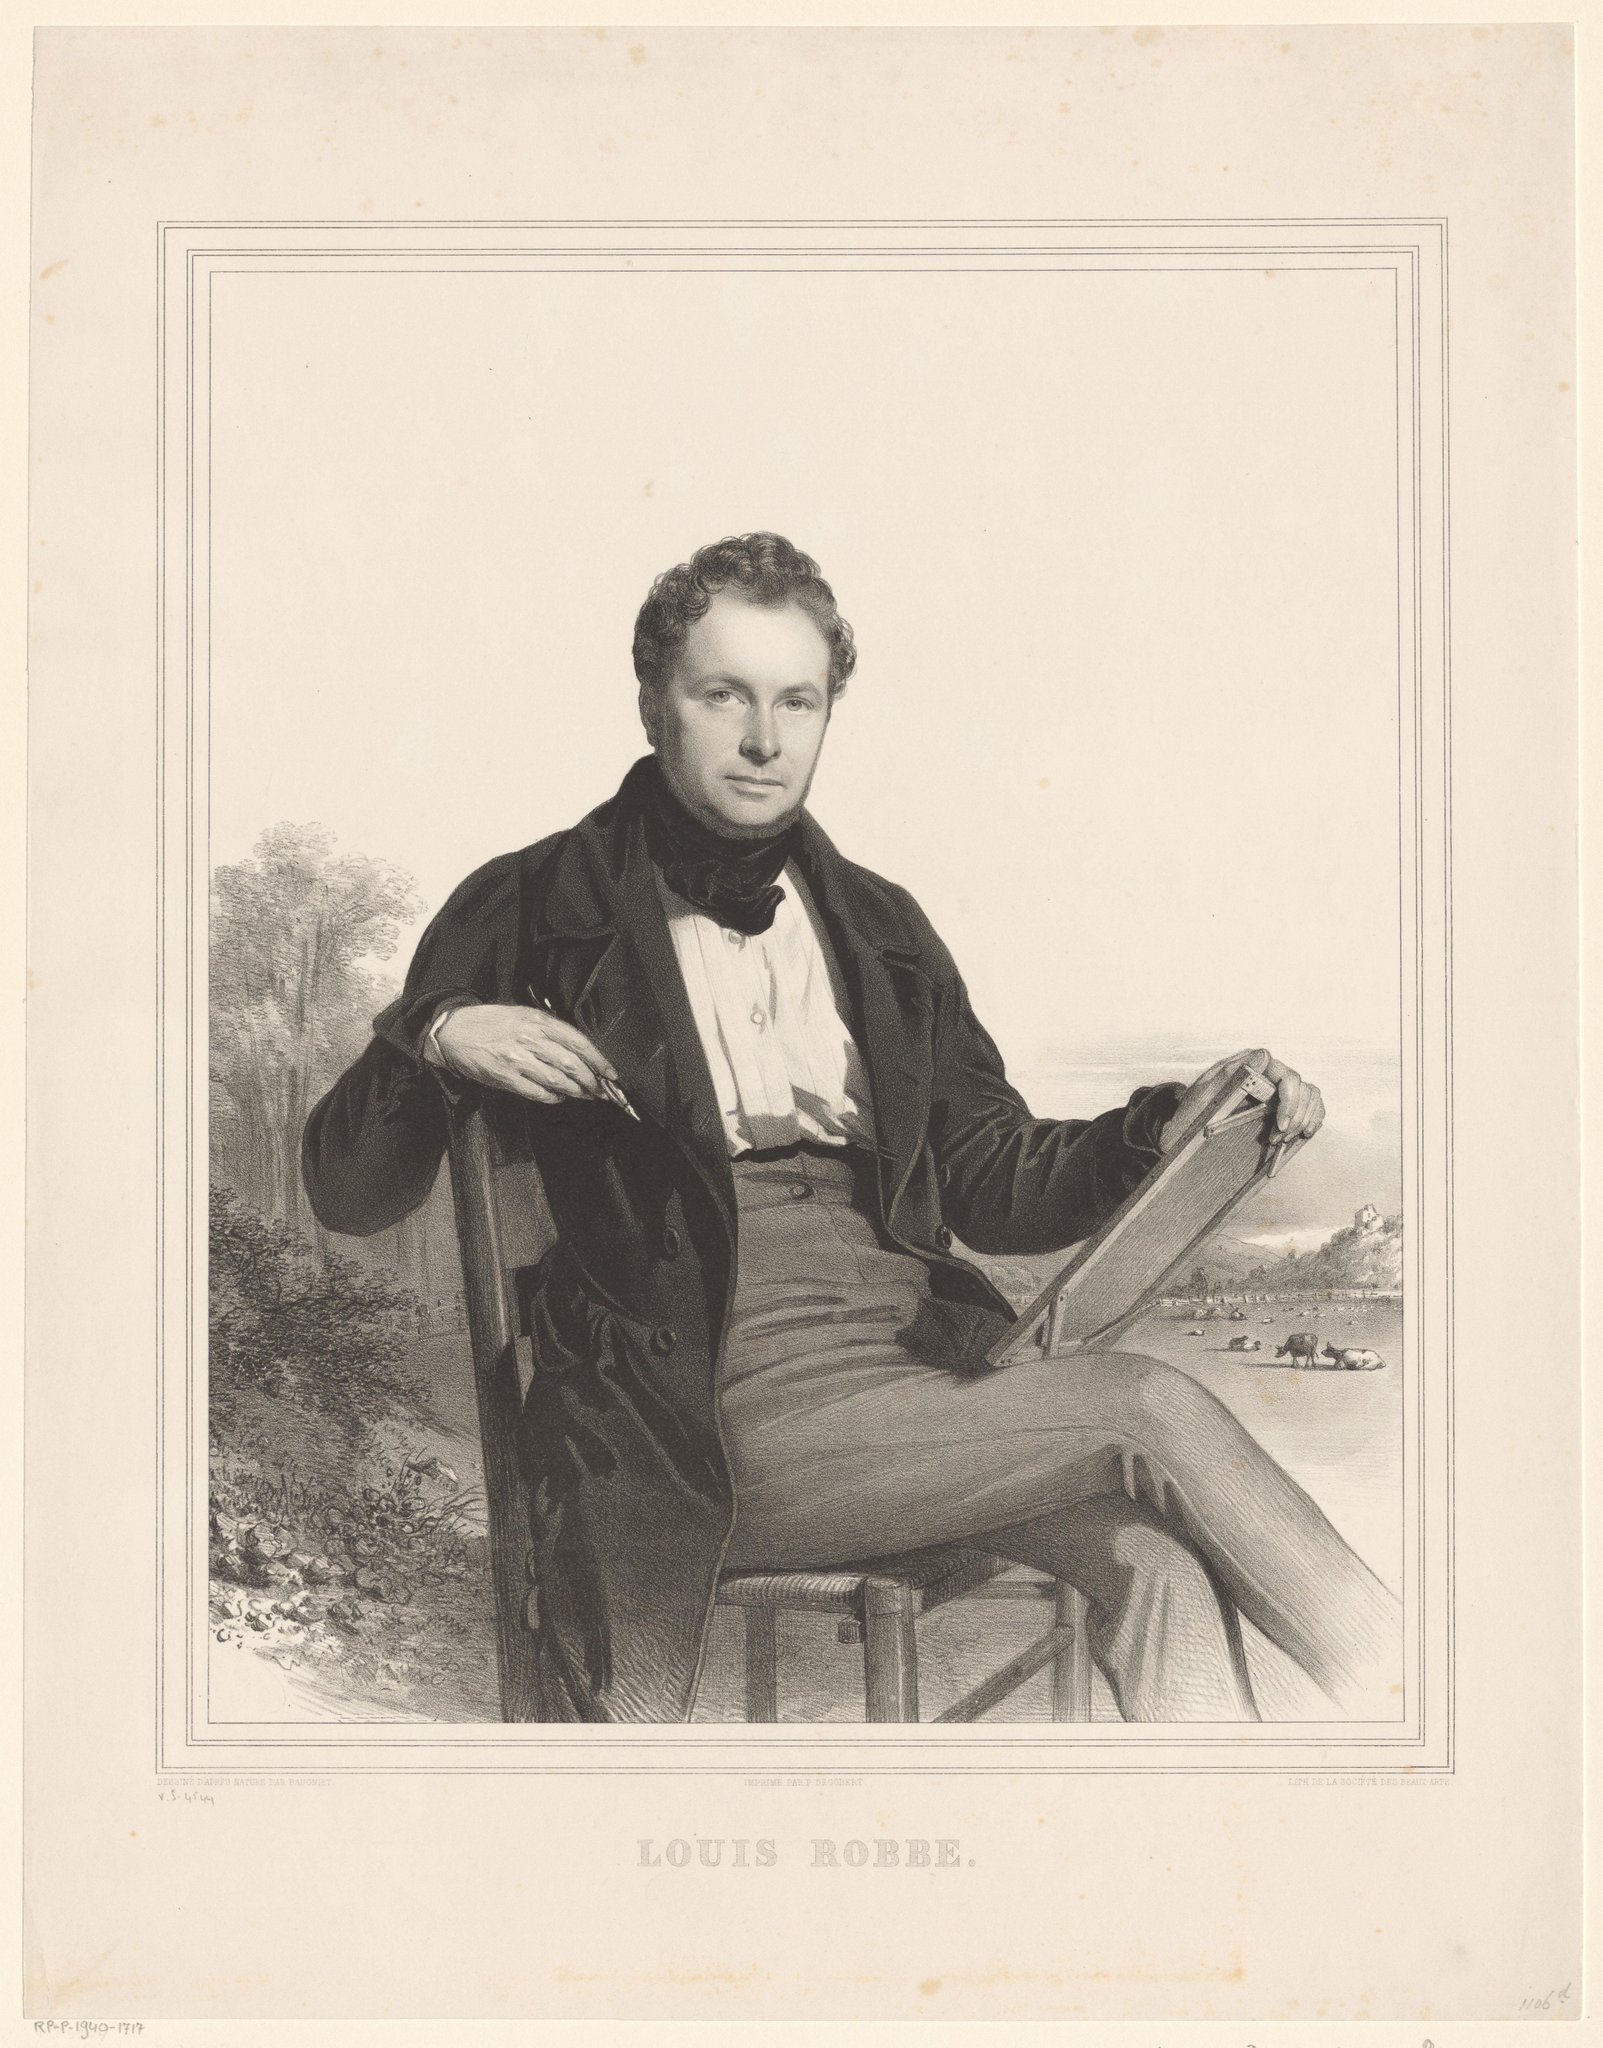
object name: print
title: Portret van Louis Robbe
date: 1838-1844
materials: paper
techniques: lithograph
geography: brussels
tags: brussels, print maker, louis robbe, cattle, historical persons, symbolic representations, allegories and emblems ~ drawing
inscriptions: collector's mark: Lugt 2760, collector's mark: Lugt 2166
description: Prent mogelijk uit: Baugniet, Charles. Les artistes contemporains: portraits lithographiés d'après nature, accompagnés de notices sur la vie et les ouvrages de chacun d'eux. Brussel: De Wasme-Pletinckx, [1836-1840].